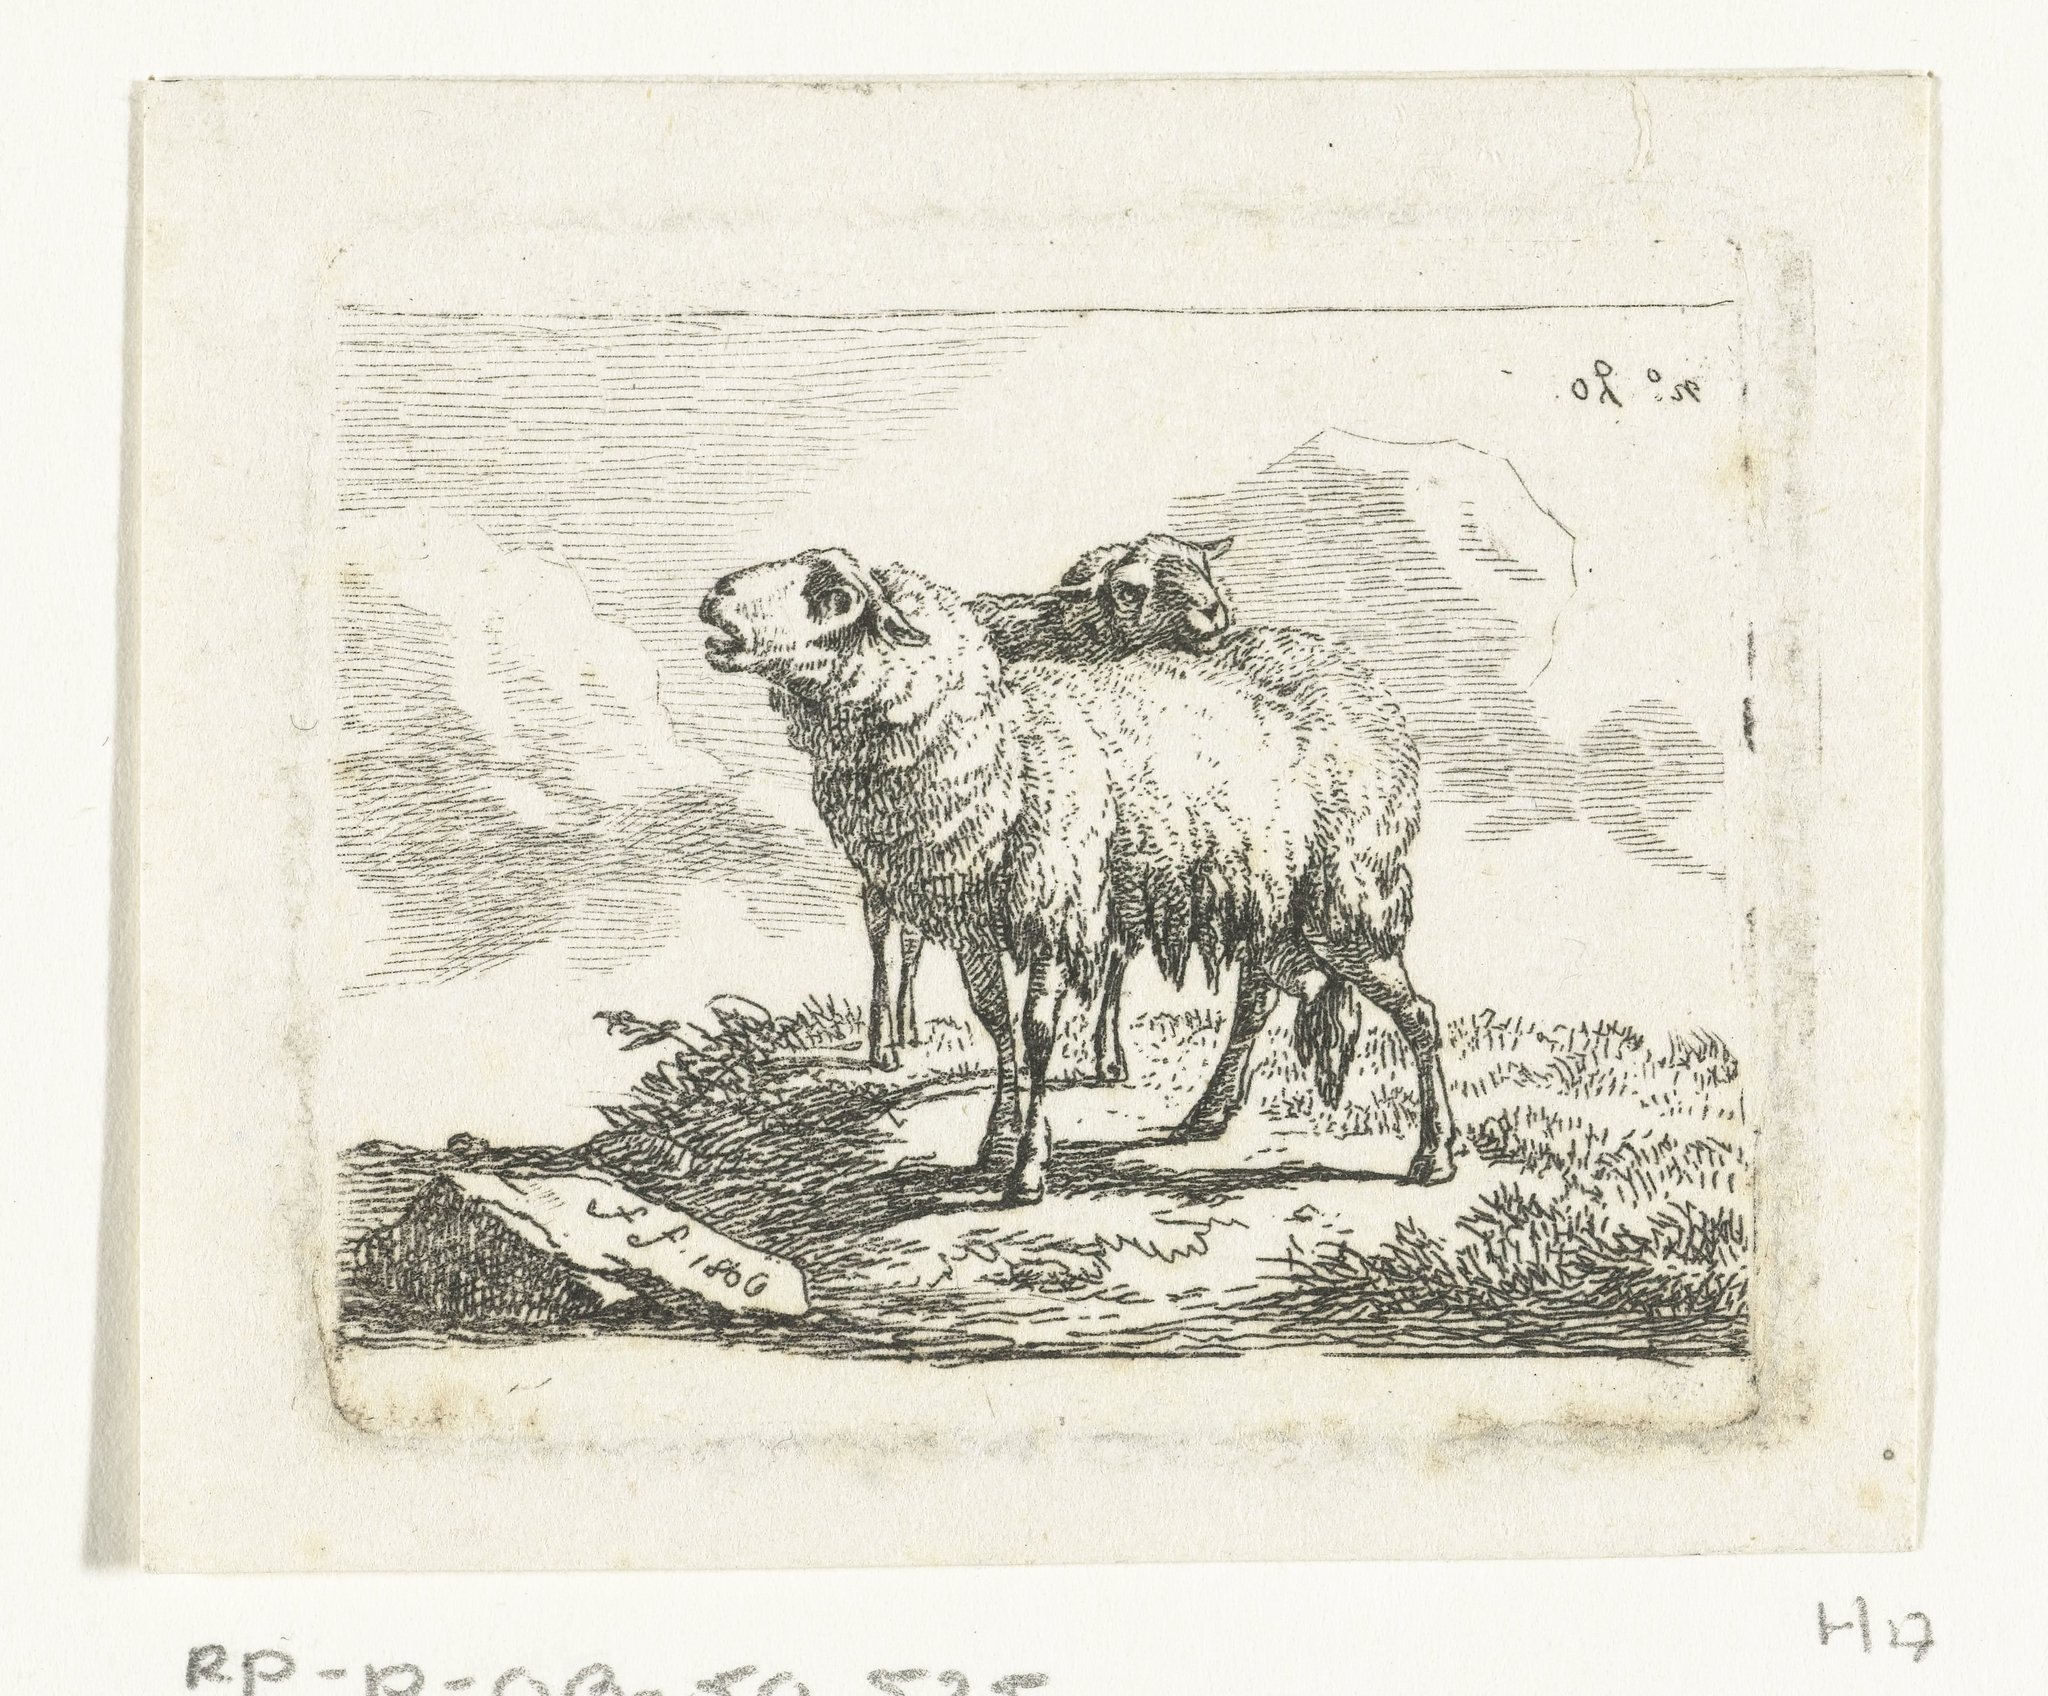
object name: print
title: Twee staande schapen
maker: frédéric théodore faber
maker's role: print maker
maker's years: 1782-1844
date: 1806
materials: paper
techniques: etching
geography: brussels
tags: sheep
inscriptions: date